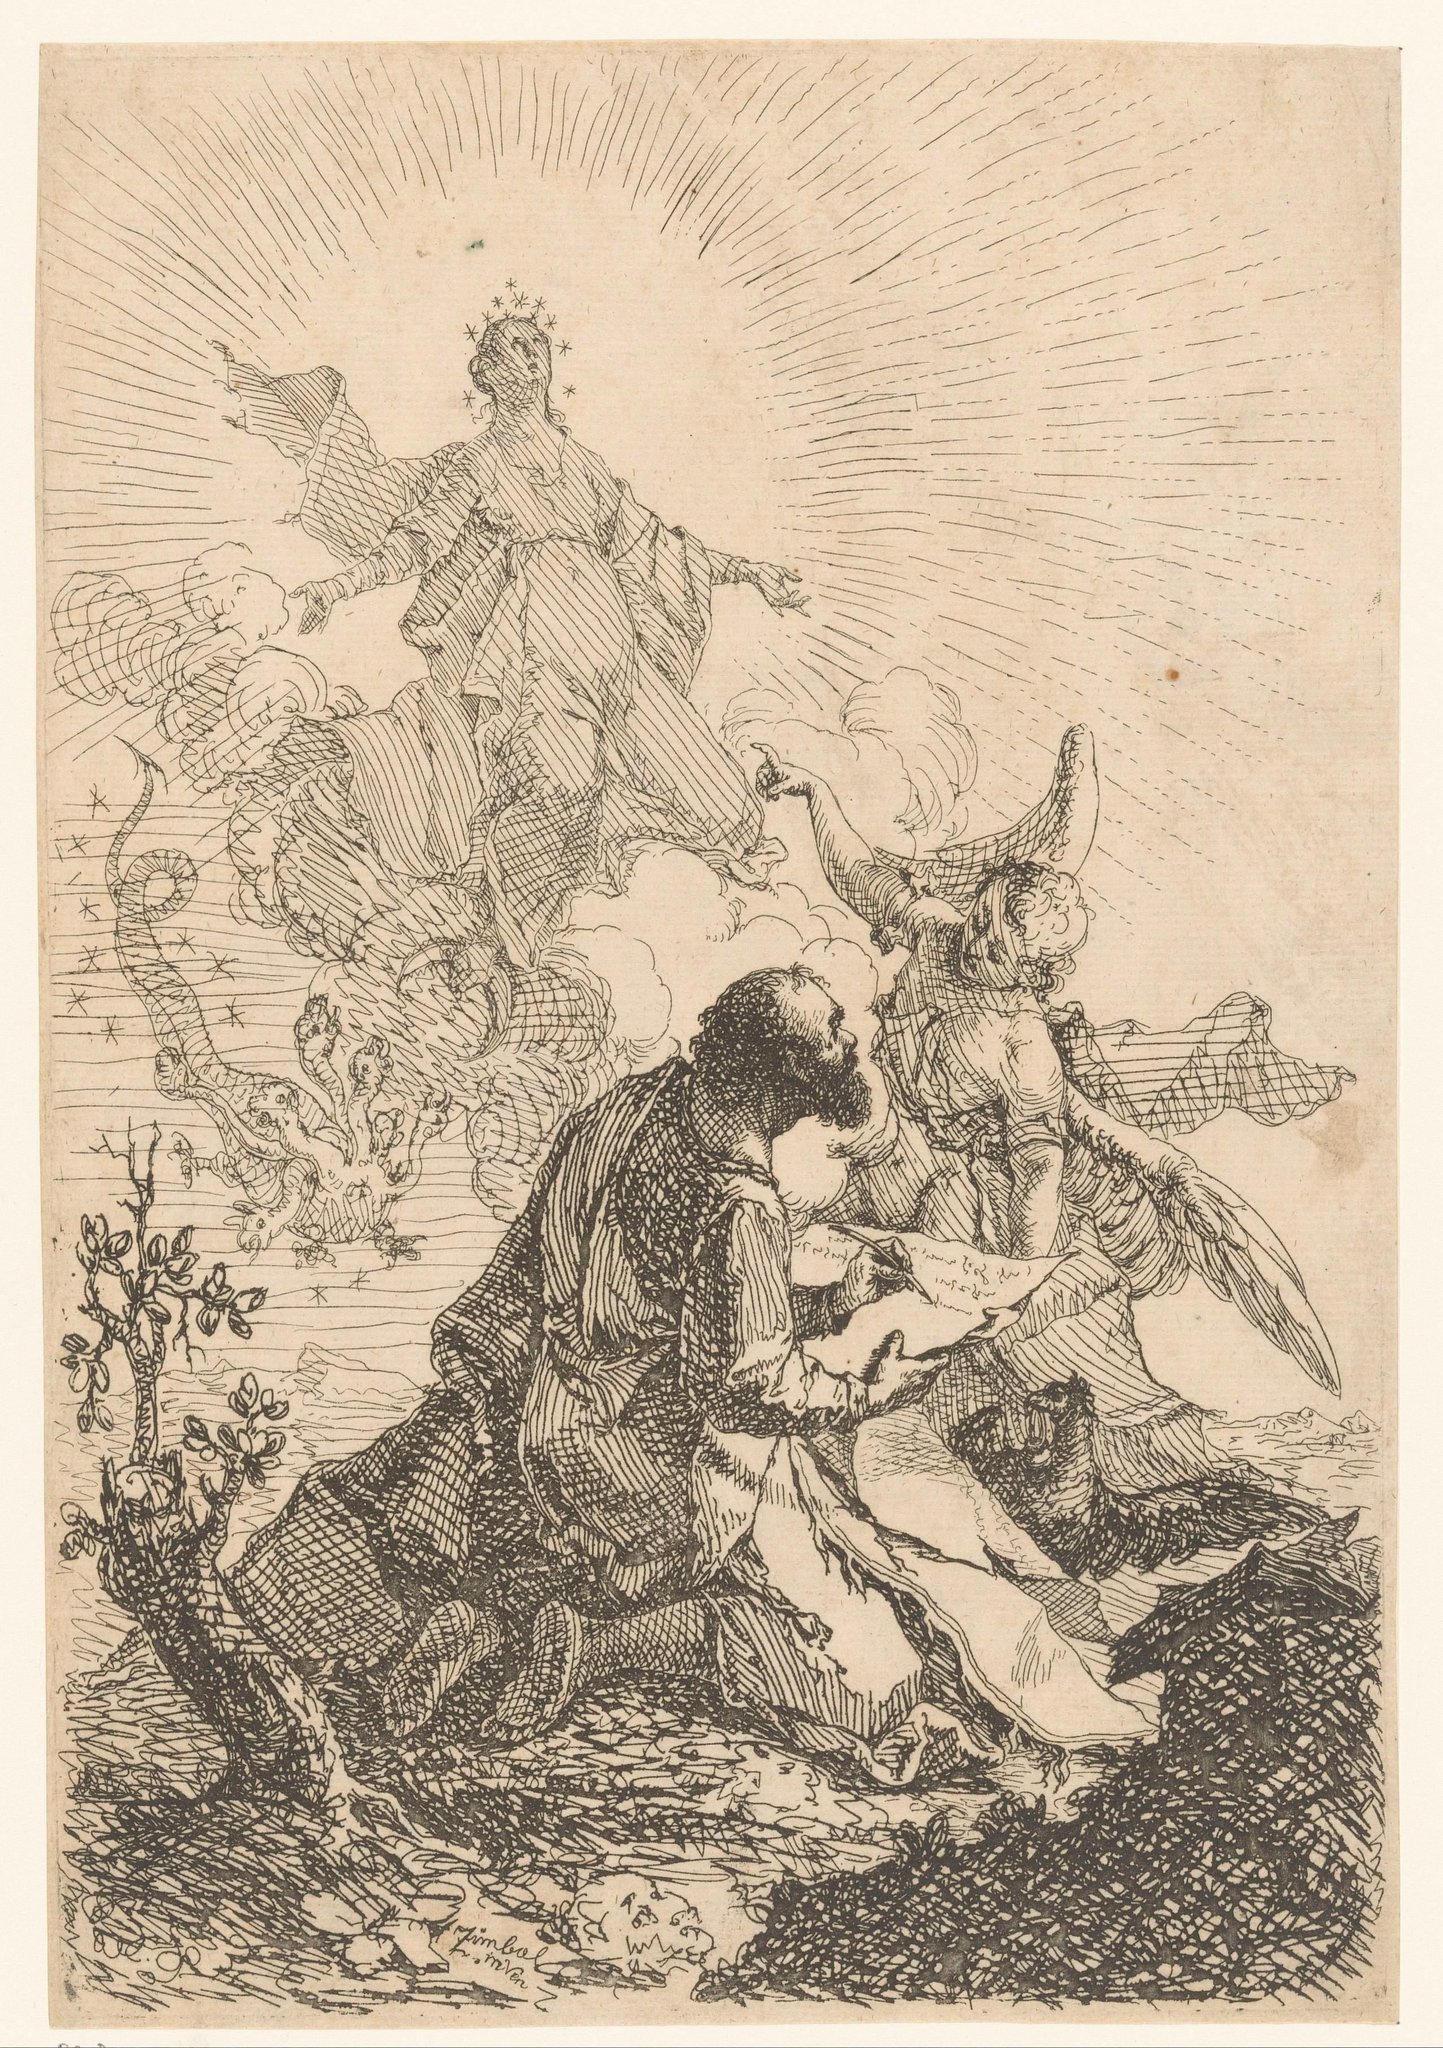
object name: print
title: Johannes krijgt op Patmos een visioen waarin de heilige maagd de zevenkoppige draak verslaat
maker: johann cimbal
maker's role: print maker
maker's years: 1722-1795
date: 1732-1795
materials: paper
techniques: etching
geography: germany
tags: a pregnant woman, clothed with the sun and standing on the moon, appears; she is threatened by a red dragon with a long tail and seven heads - gg - mary as the apocalyptic woman, john (writing) on the island of patmos, possibly the eagle beside him, angels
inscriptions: collector's mark, collector's mark: Lugt 2760, collector's mark: Lugt 2228